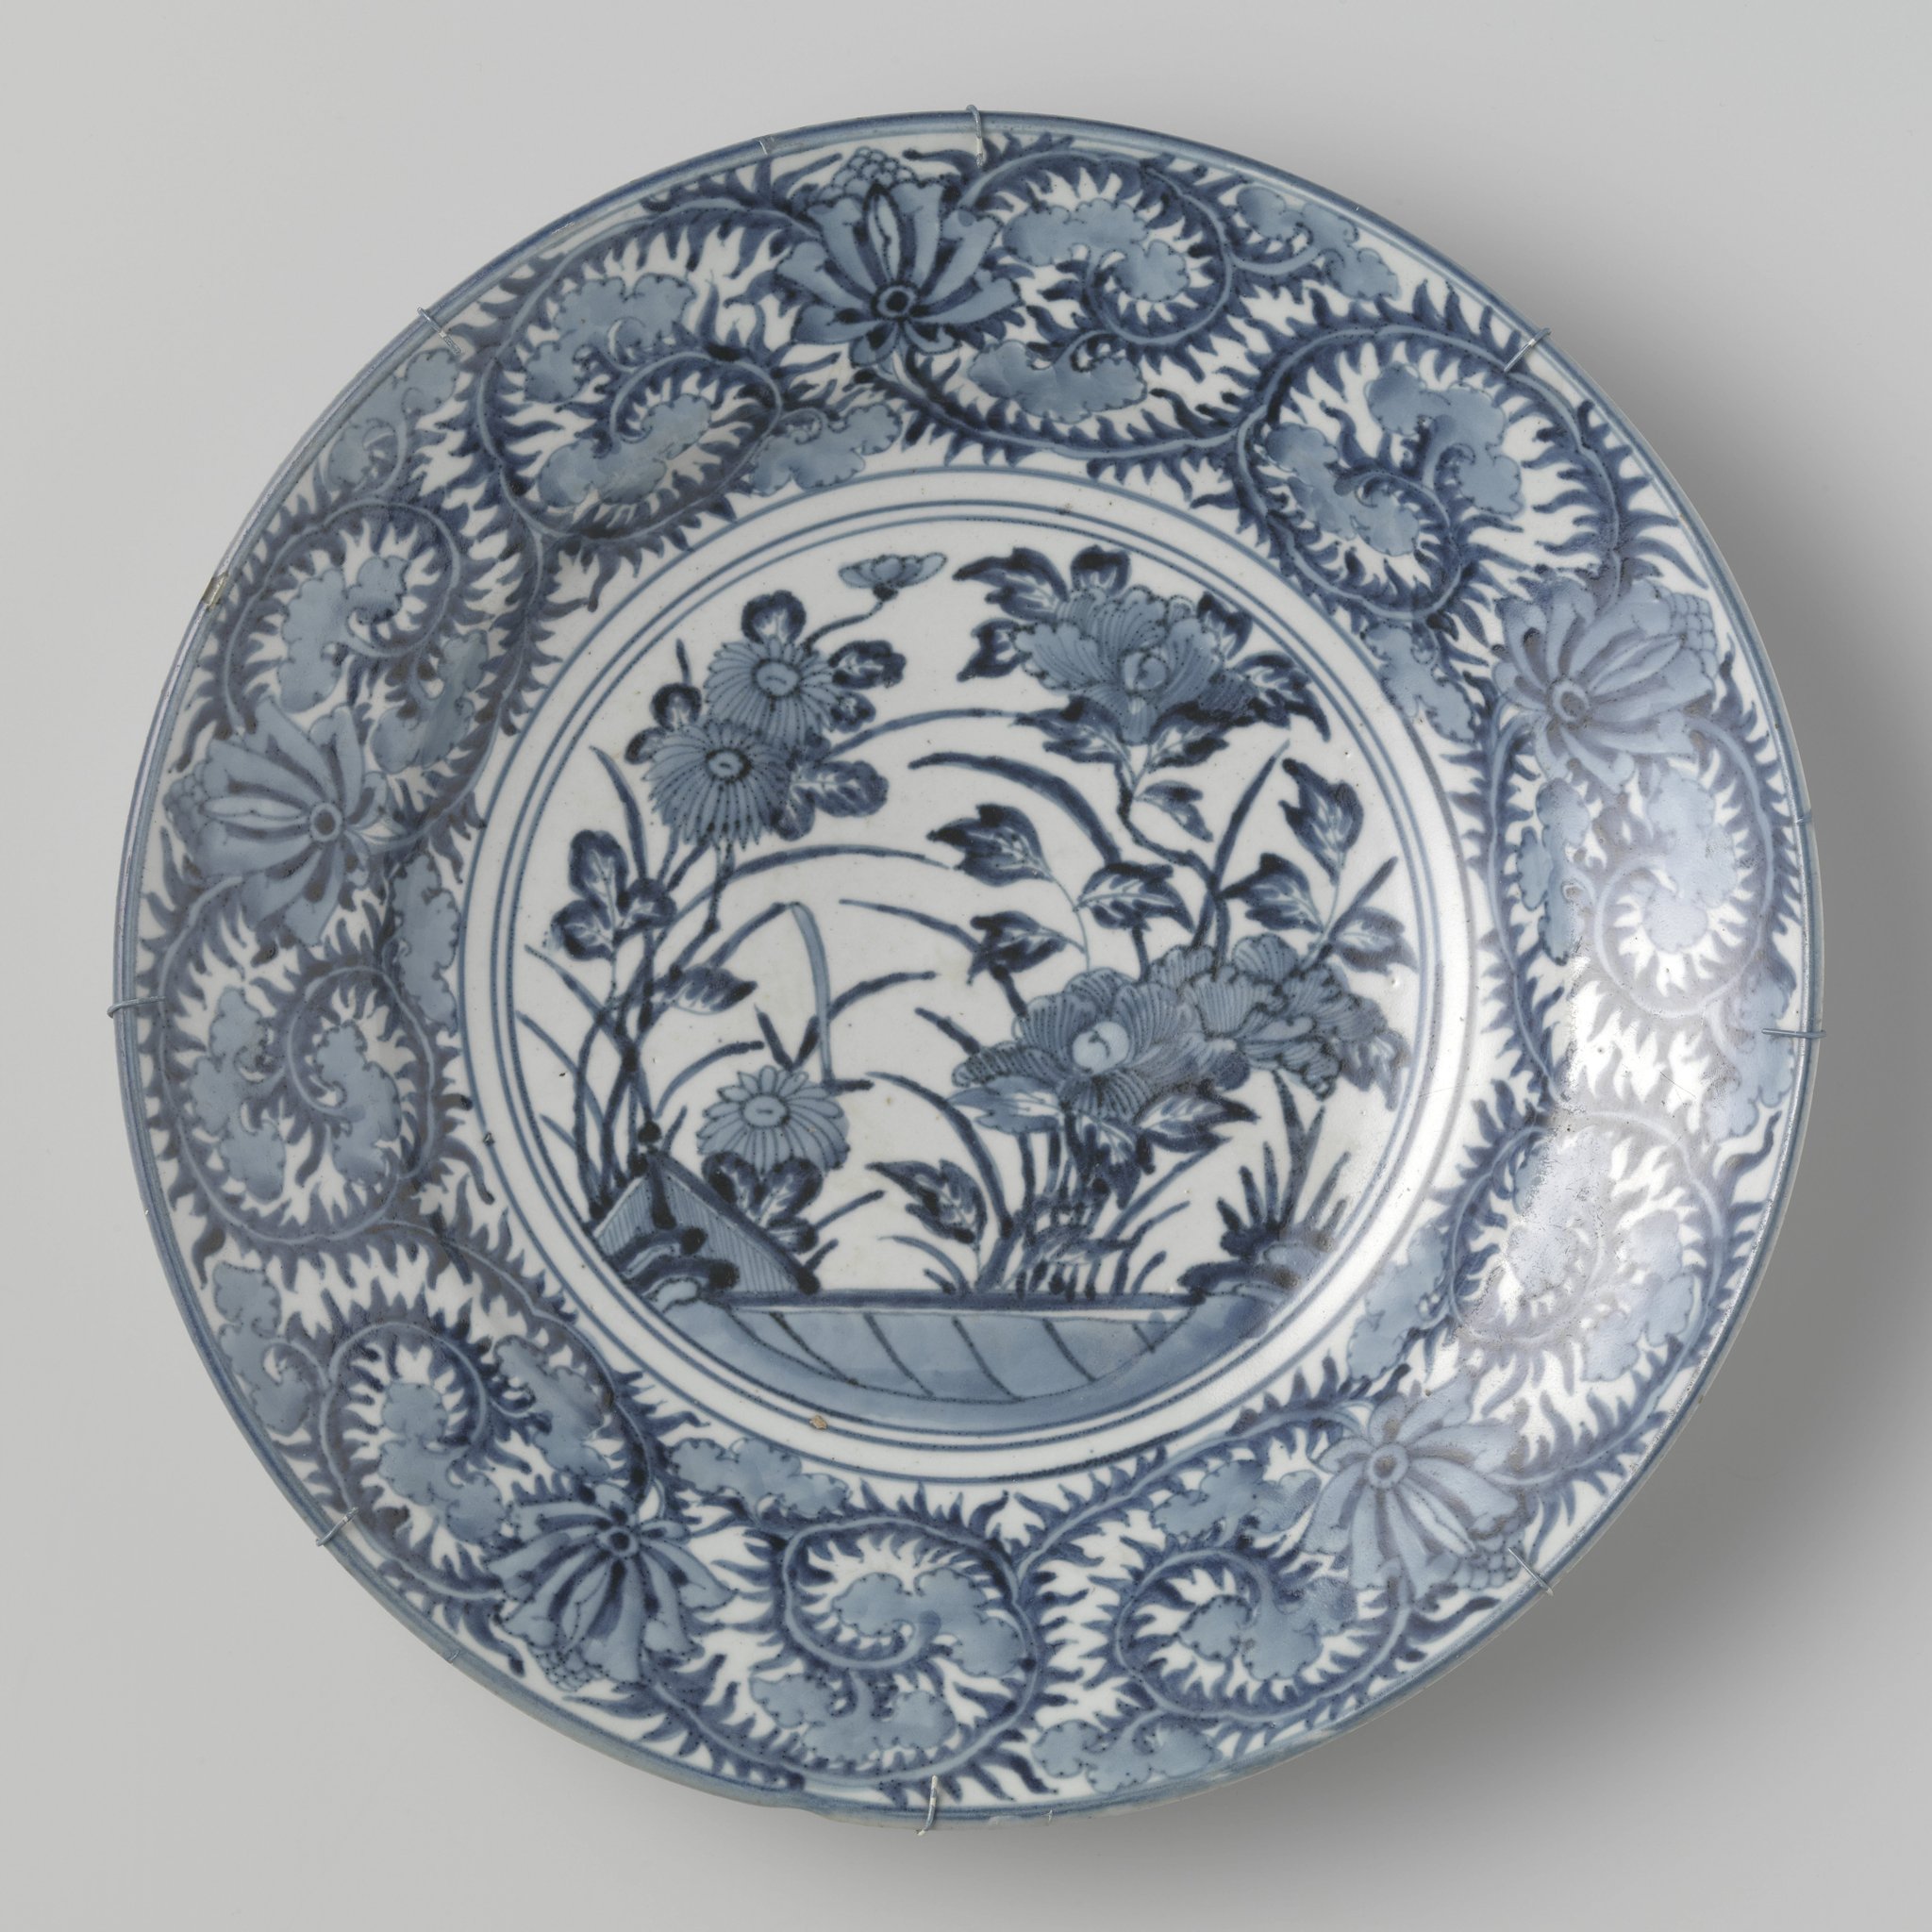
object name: platter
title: Dish with chrysanthemums and peonies behind a fence and lotus scrolls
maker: Anonymous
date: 1650-1699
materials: cobalt, glaze, iron, paint, porcelain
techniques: firing, turning, vitrification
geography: japan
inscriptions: label: ‘Van der Ven en Van der Ven Antiquairs’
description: Plate. Porcelain, blue underglaze. Japan, 1680 - 1700.